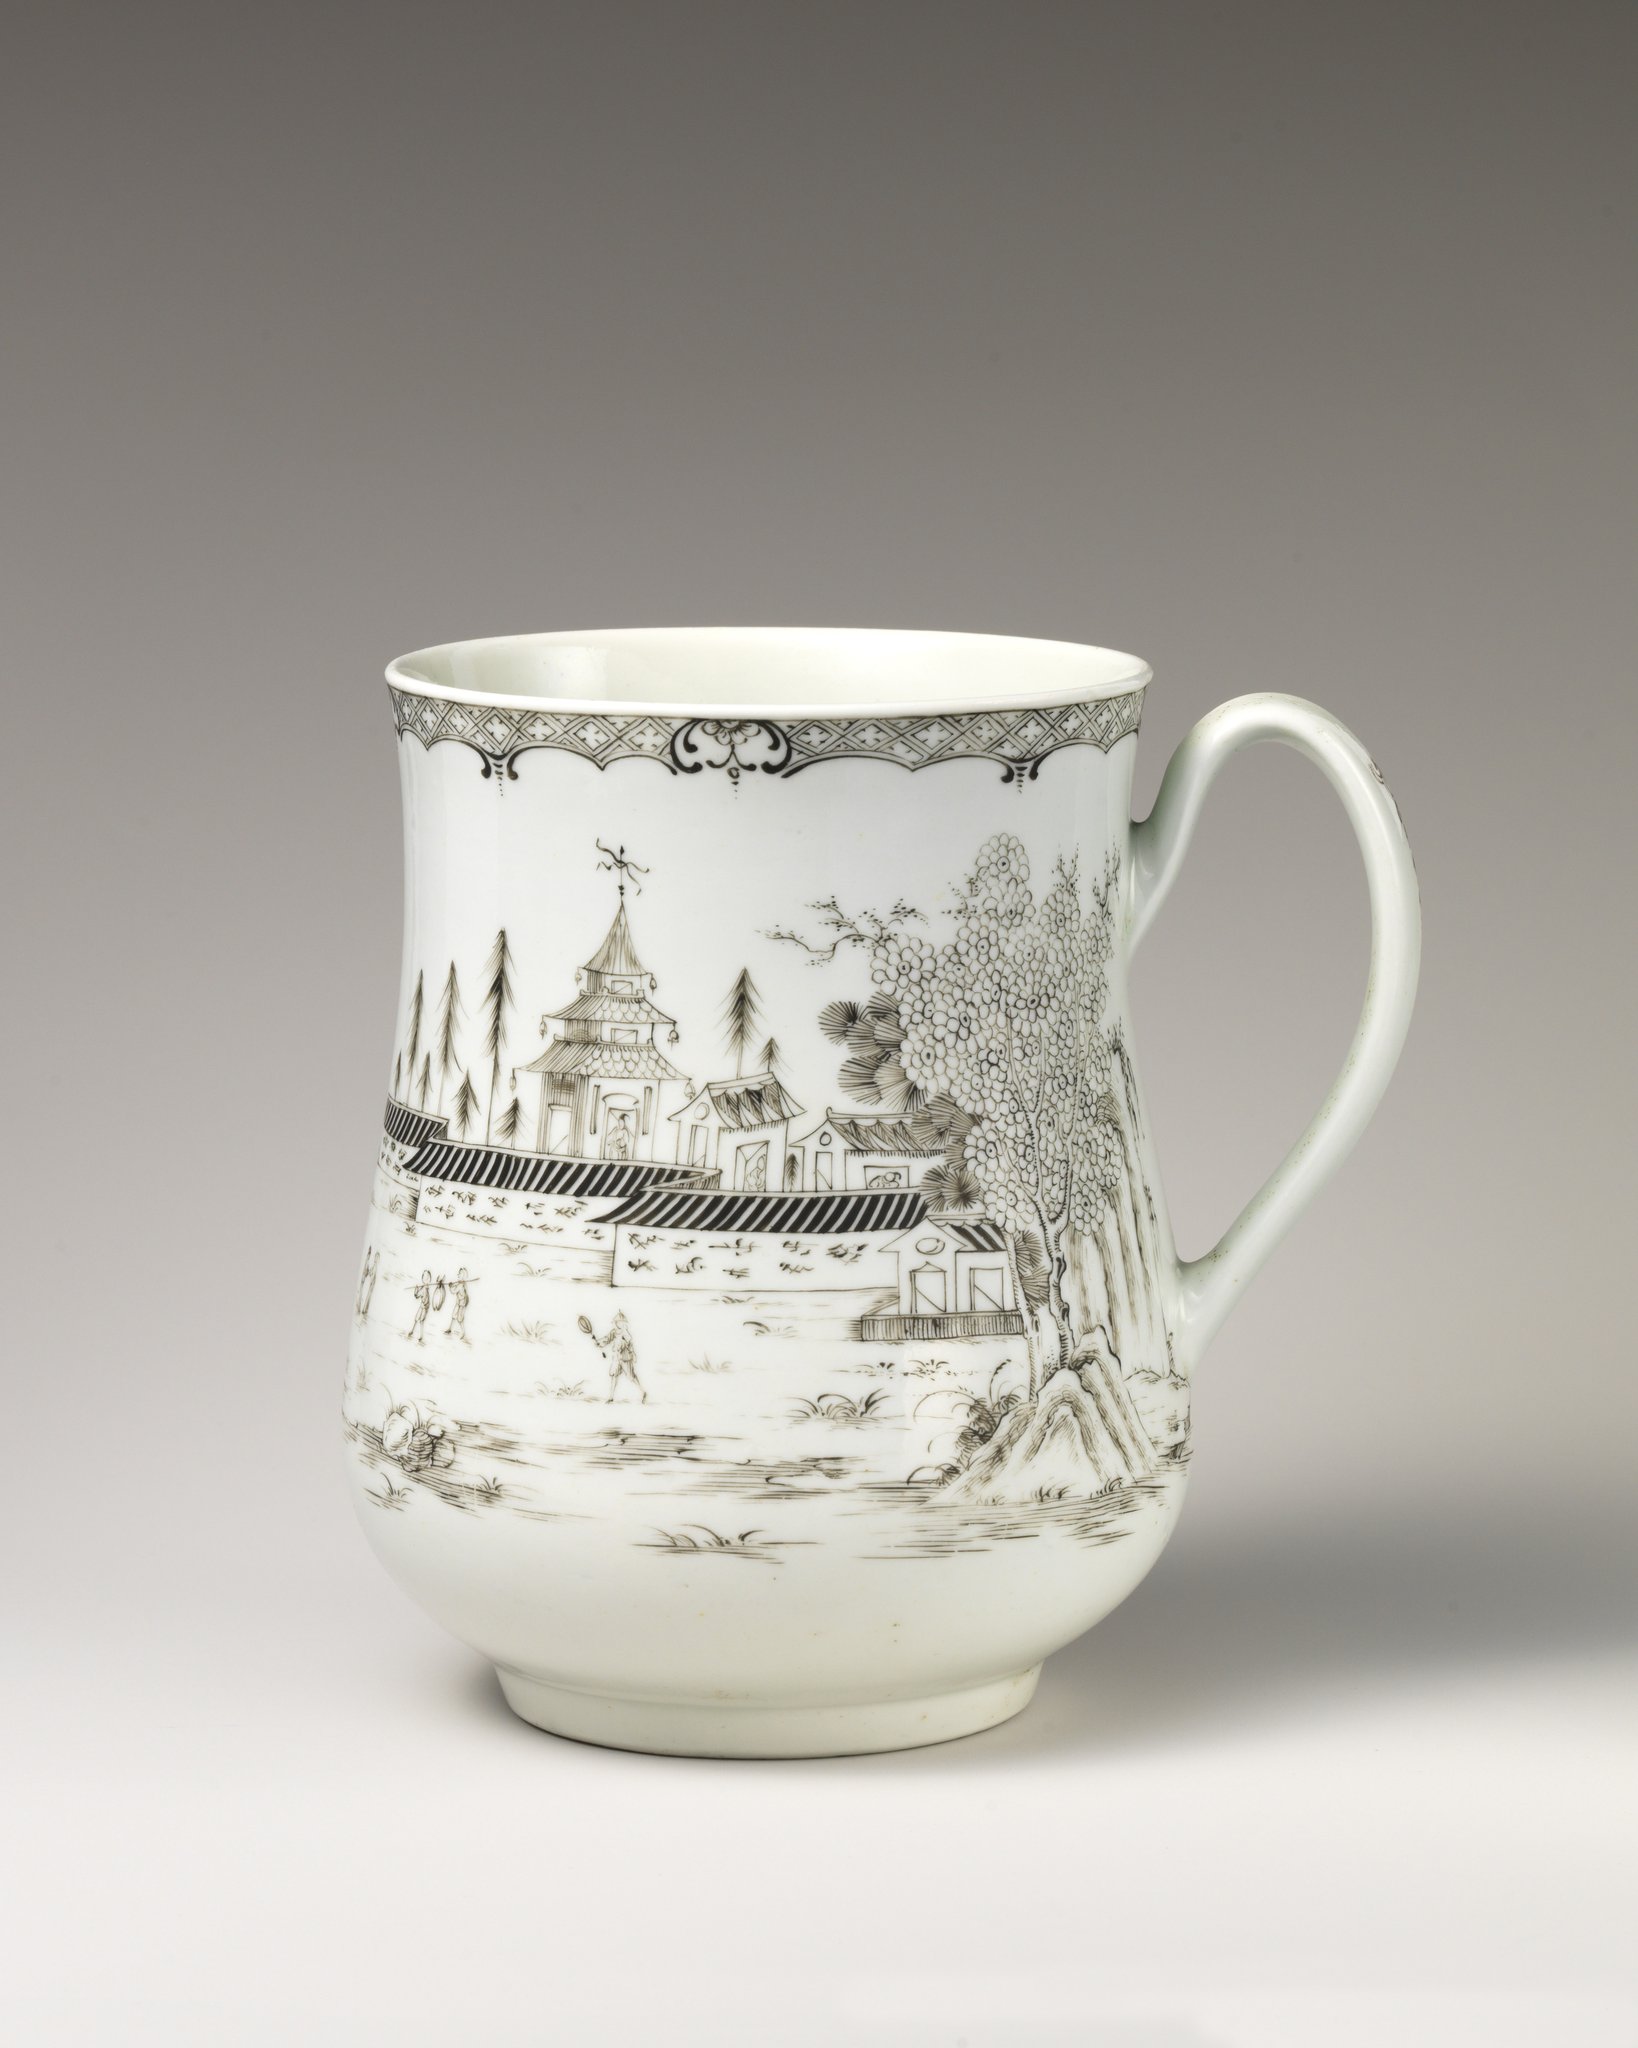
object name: tankard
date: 1701-1800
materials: soft paste porcelain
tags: houses,trees